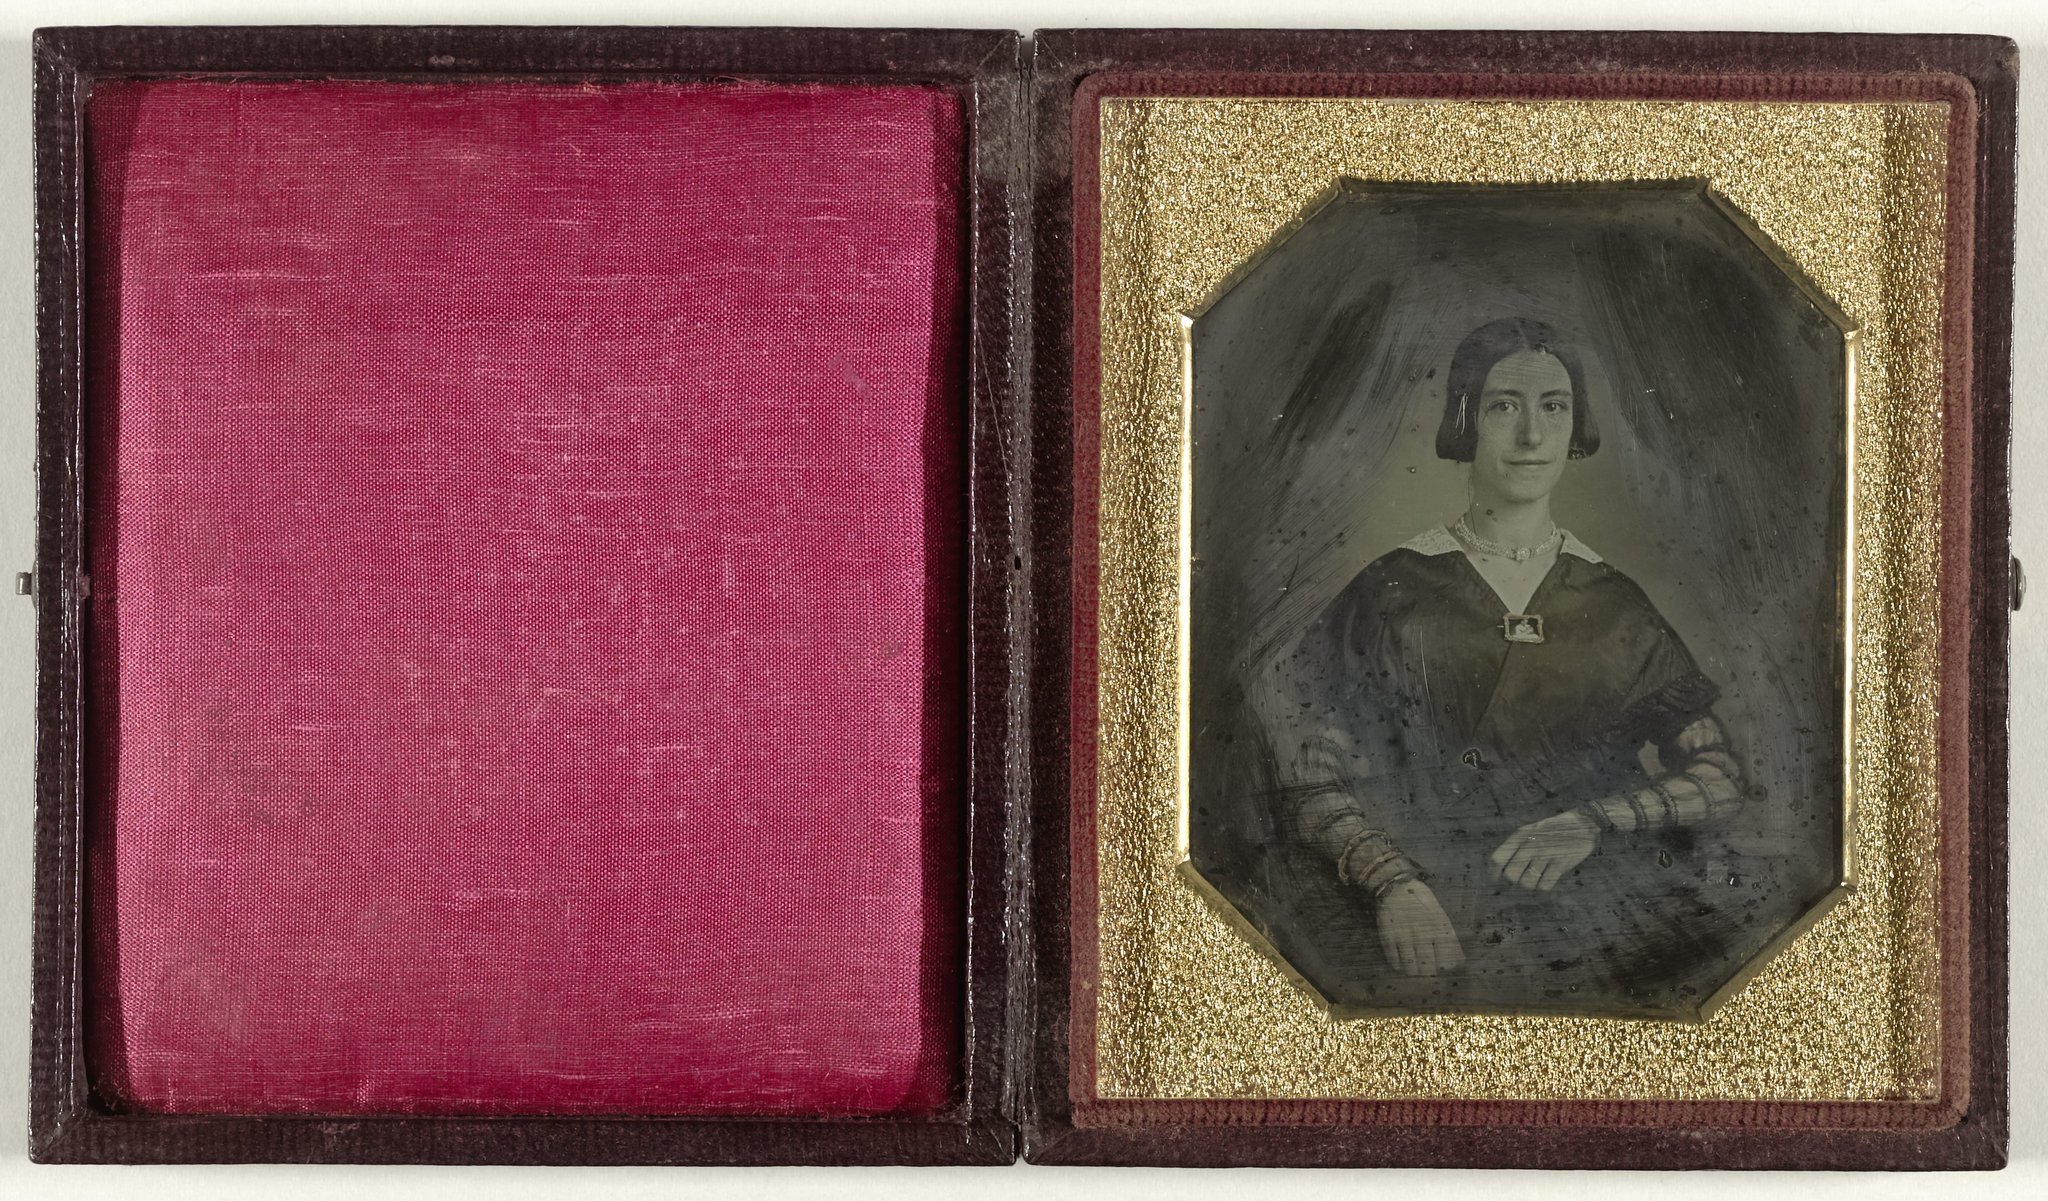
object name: photograph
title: Portret van Adolphina Juliana Lisman-Meyer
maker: Anonymous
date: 1849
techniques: daguerreotype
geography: paramaribo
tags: historical persons - bb - woman, suriname